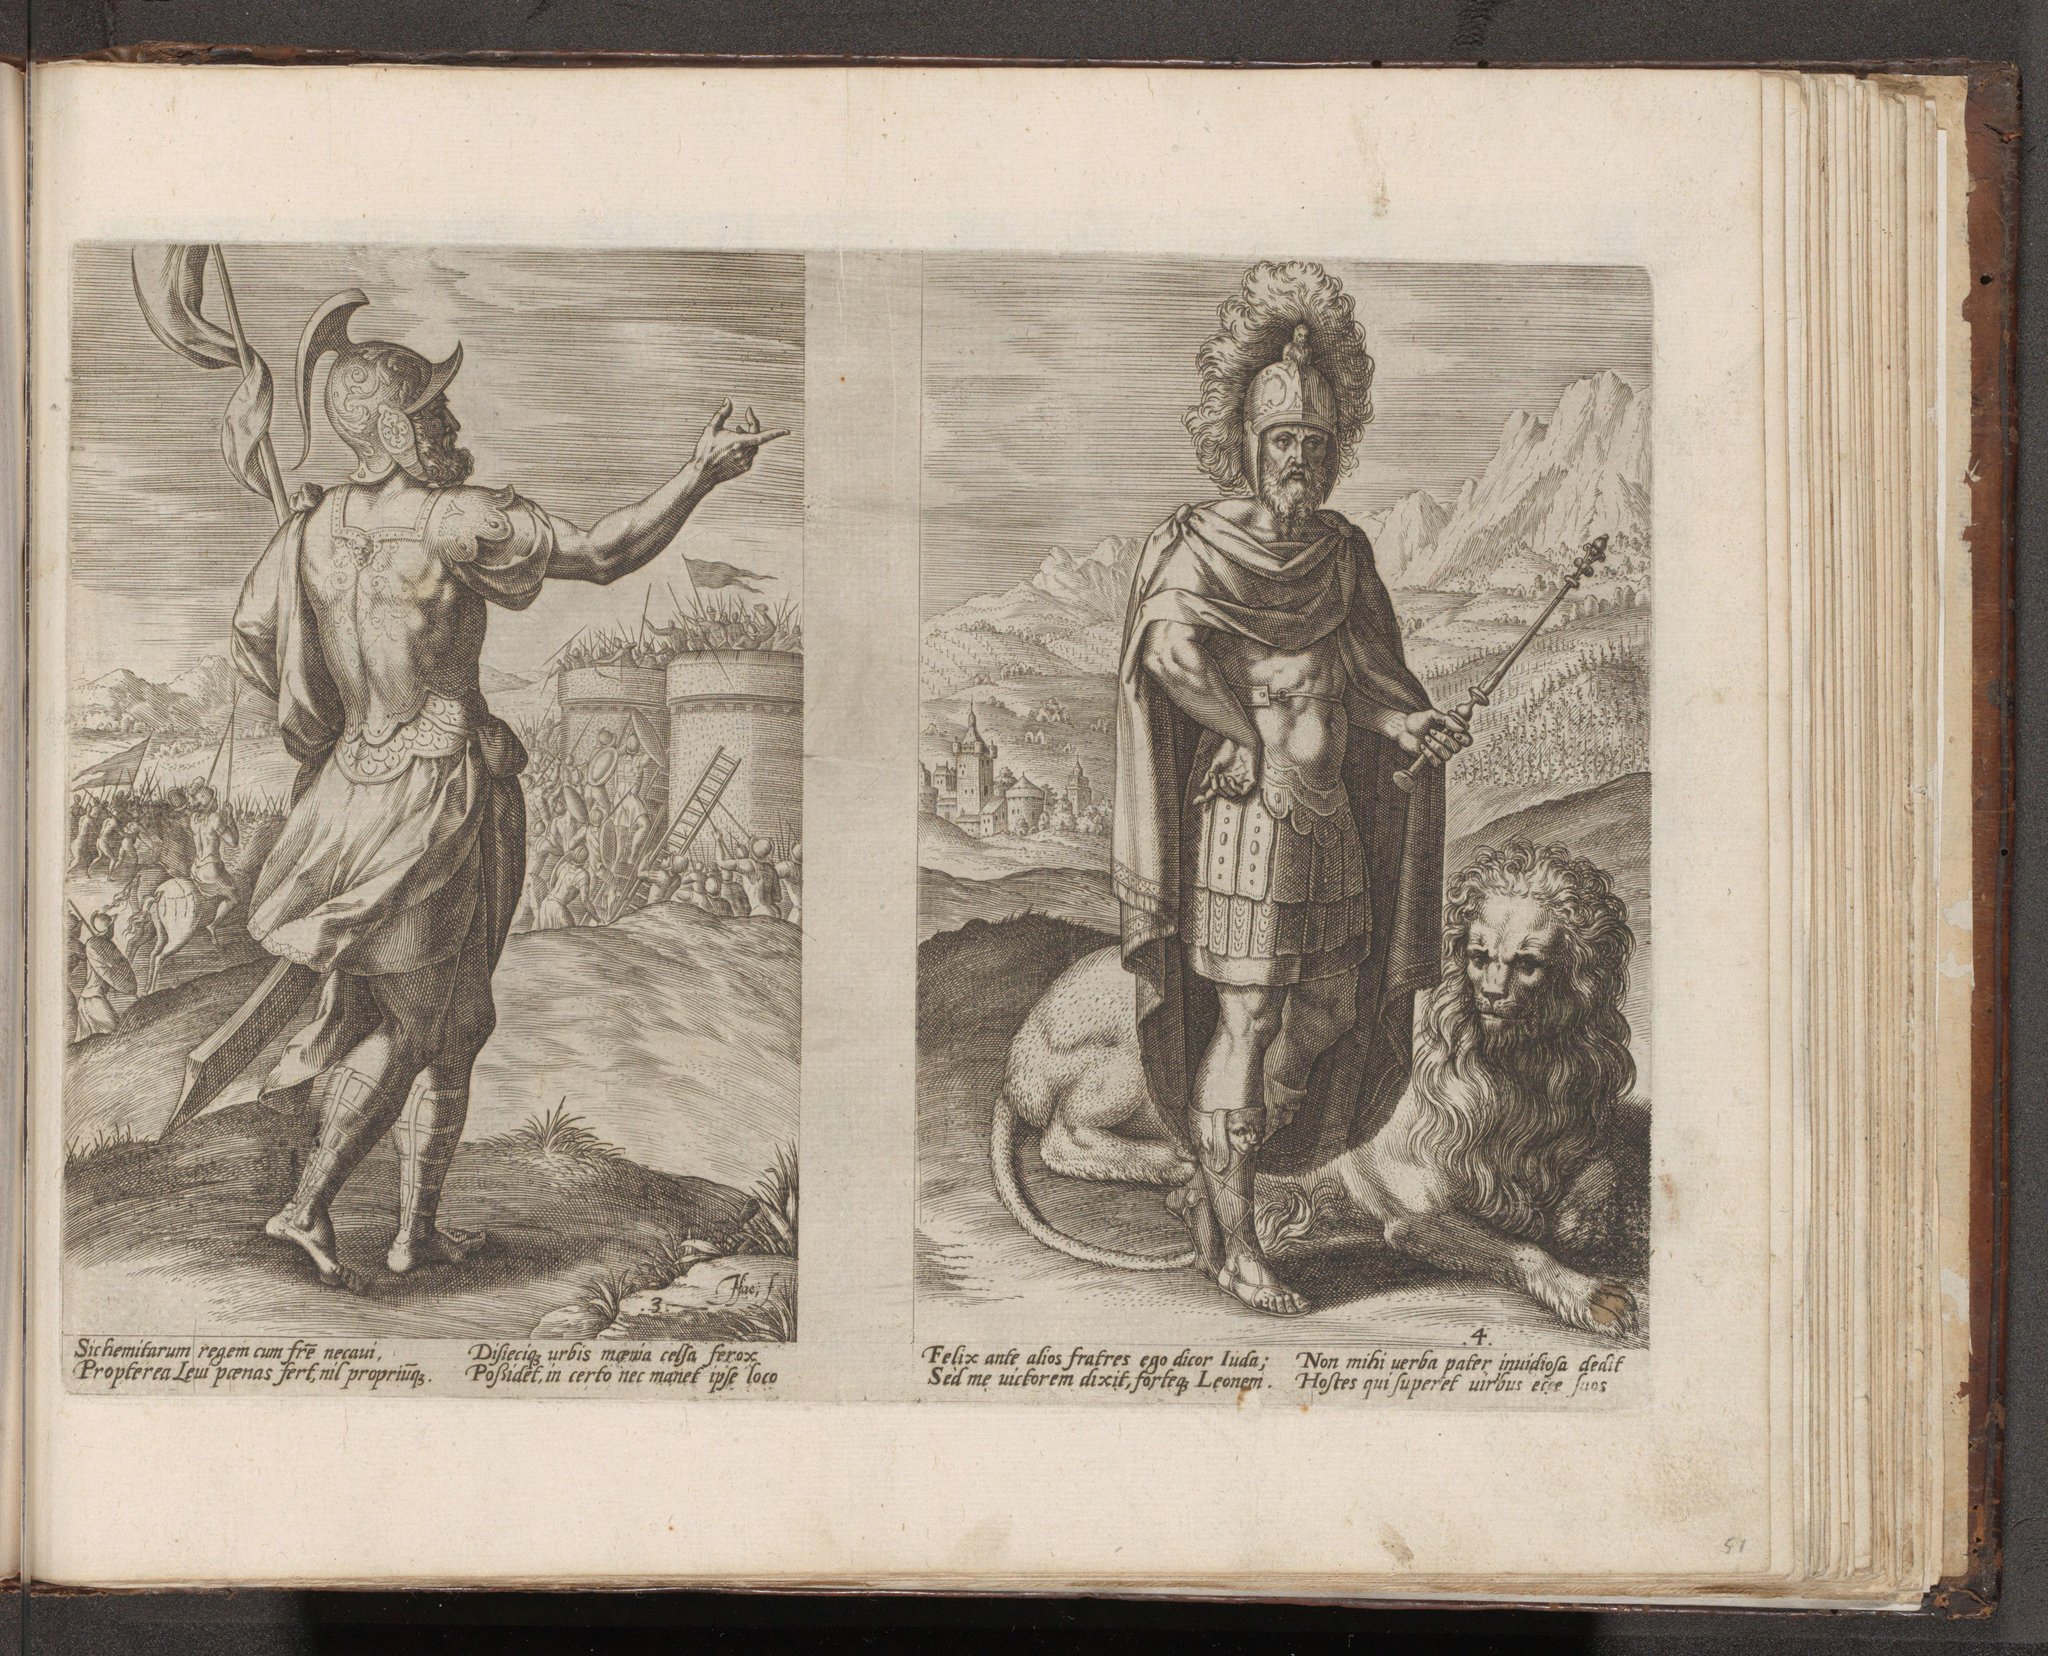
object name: album leaf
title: Stamvaders Levi en Juda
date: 1579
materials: paper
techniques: engraving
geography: antwerp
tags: 11i611(juda), 11i611(levi)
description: Links stamvader Levi, de derde zoon van Jakob, in wapenrusting. Op de achtergrond de belegering van de stad Sichem, die Levi samen met Simeon vernietigde als wraak voor het onteren van hun zus Dina. Rechts stamvader Juda, de vierde zoon van Jakob, in wapenrusting. Aan zijn zijde een leeuw, een verwijzing naar de vergelijking die zijn vader Jakob maakte tussen Juda en een leeuw. Onder de voorstellingen een verwijzing in het Latijn naar de Bijbeltekst. Prent maakt deel uit van een album.